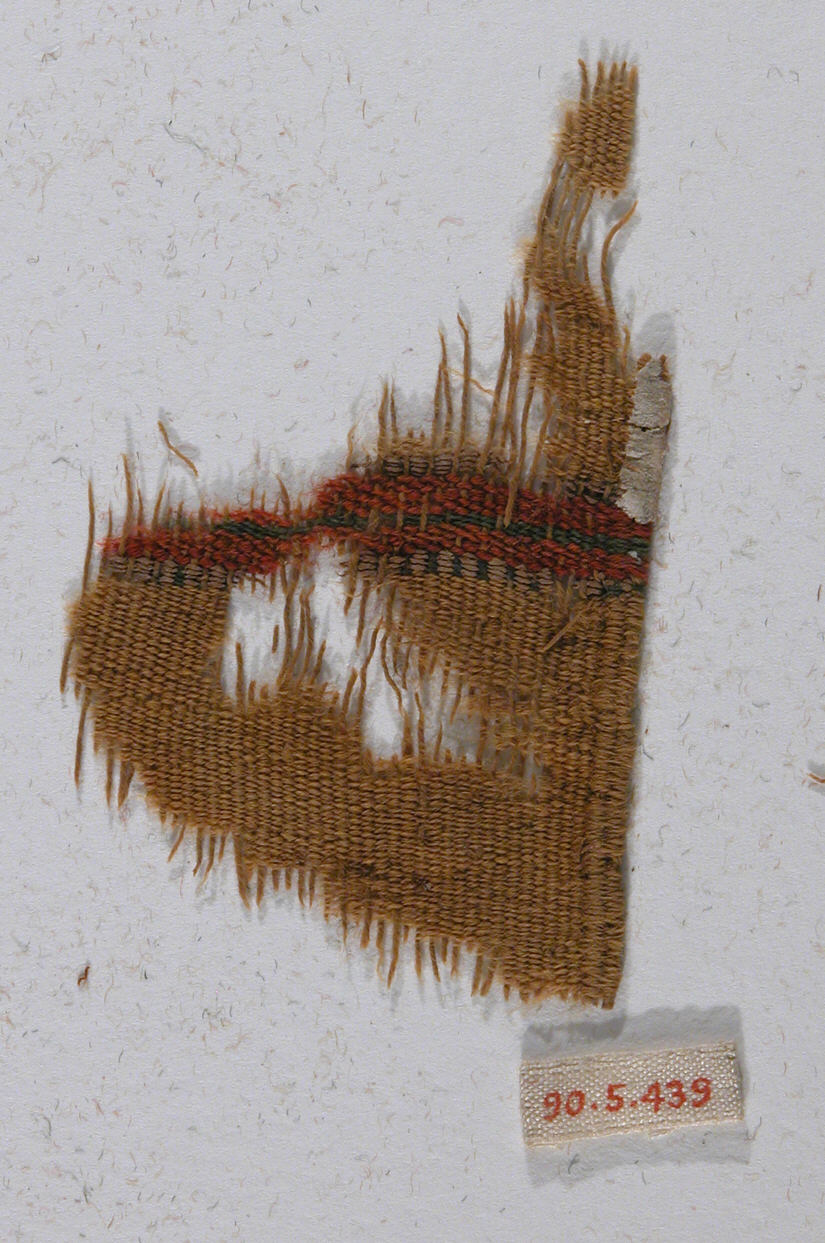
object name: textile fragment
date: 301-500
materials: linen, wool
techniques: weave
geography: egypt